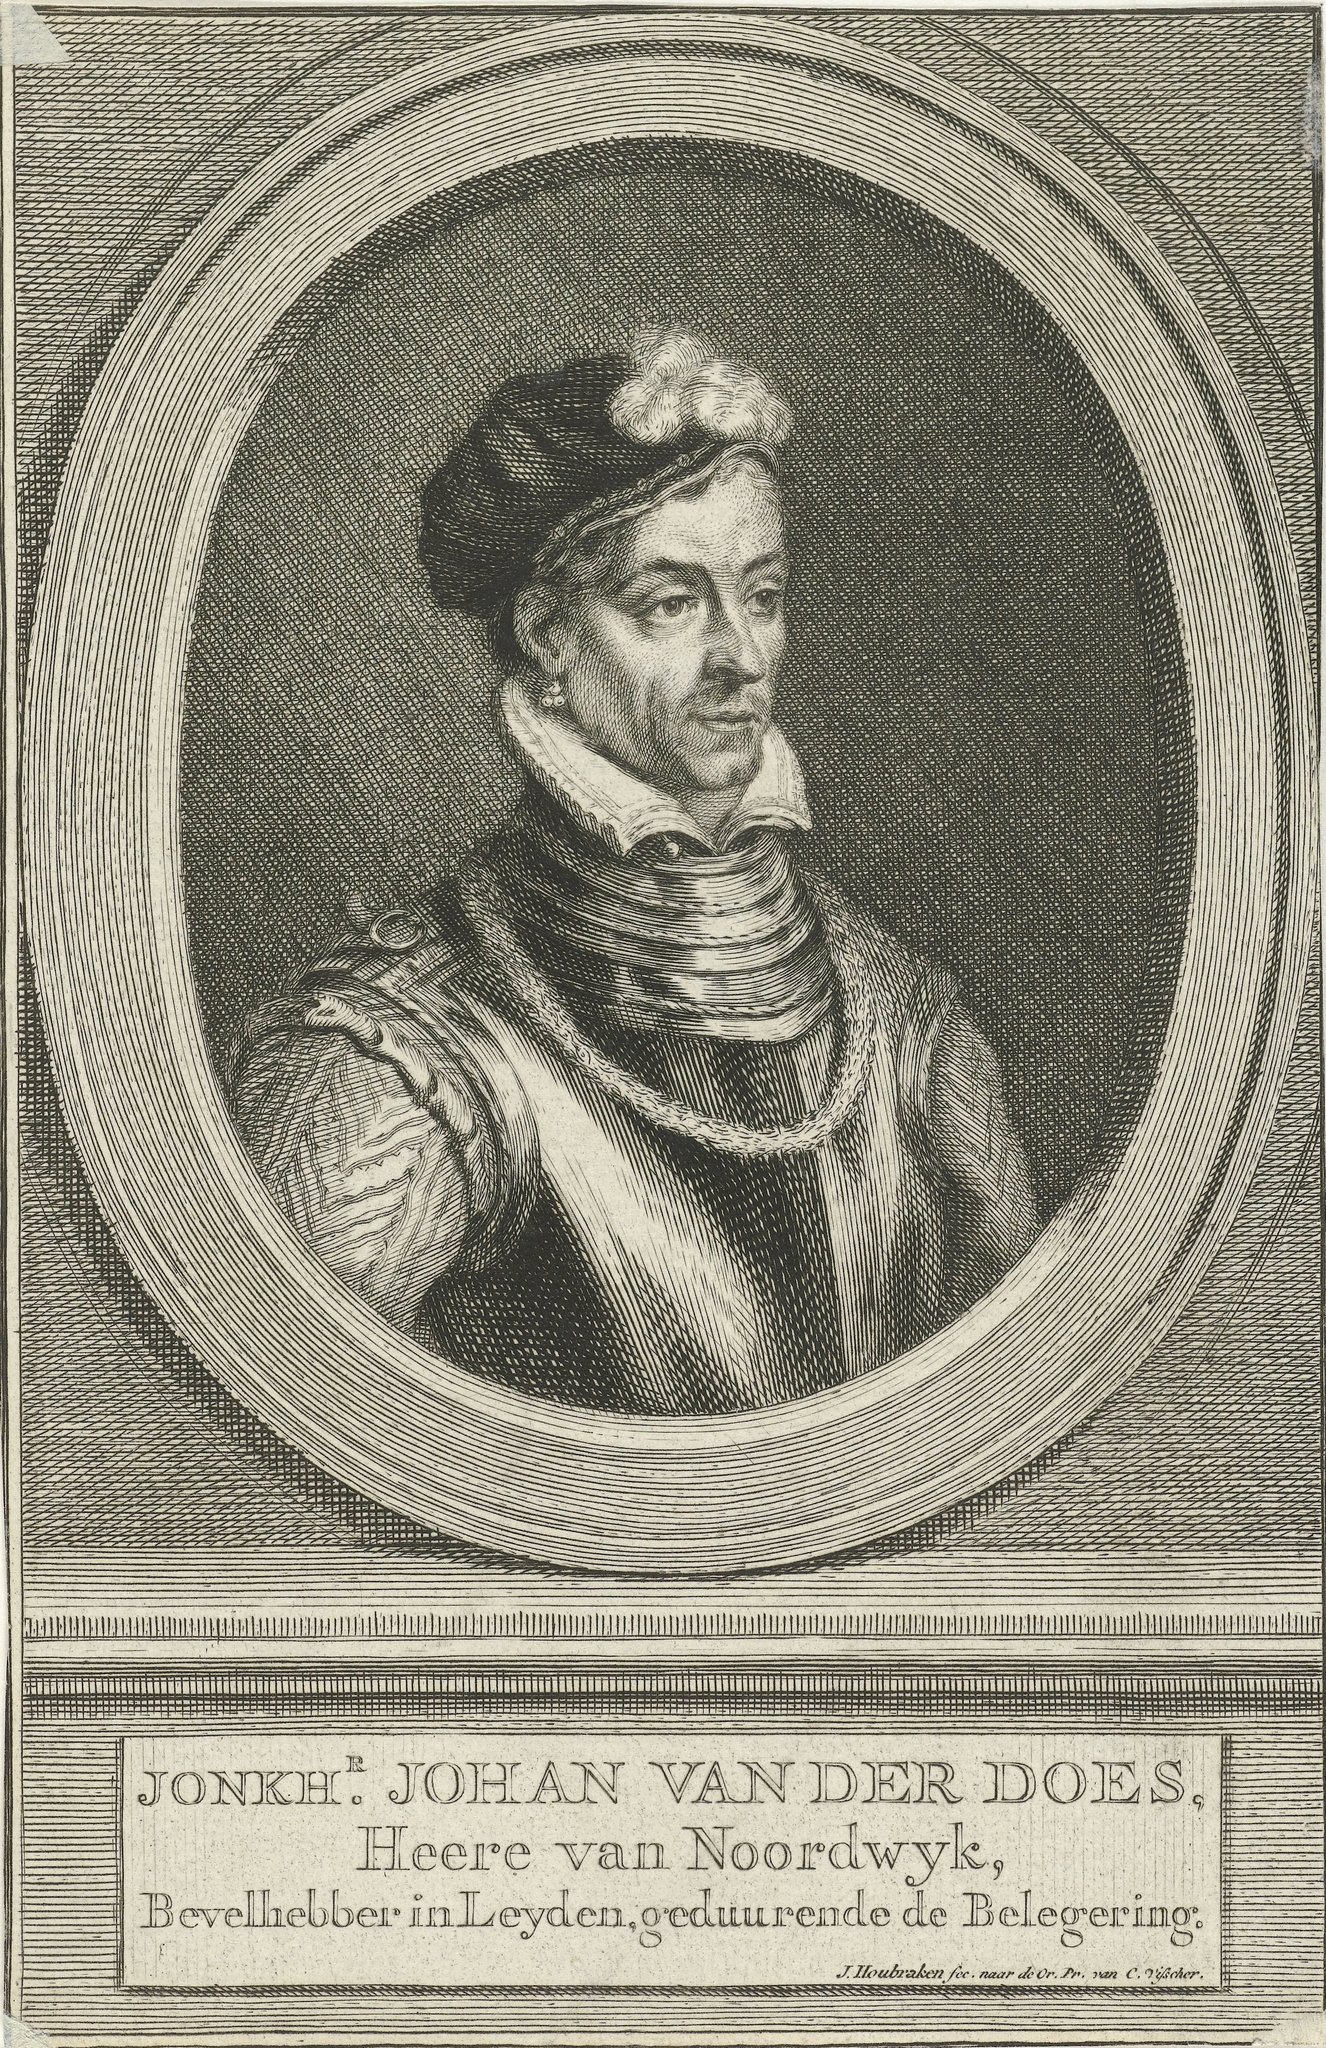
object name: print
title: Jonkhr. Johan van der Does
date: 1749-1759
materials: paper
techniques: engraving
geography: amsterdam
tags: bevelhebber, dichter, filoloog, bibliothecaris, bestuurder, jan van der does (heer van noordwijk en kattendijke)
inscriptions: collector's mark: Lugt 2228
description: Prent ook gebruikt in: Jan Wagenaar, Vaderlandsche historie, vervattende de geschiedenissen der nu Vereenigde Nederlanden, inzonderheid die van Holland (...), 21 delen. Amsterdam, Isaak Tirion, 1749-59.